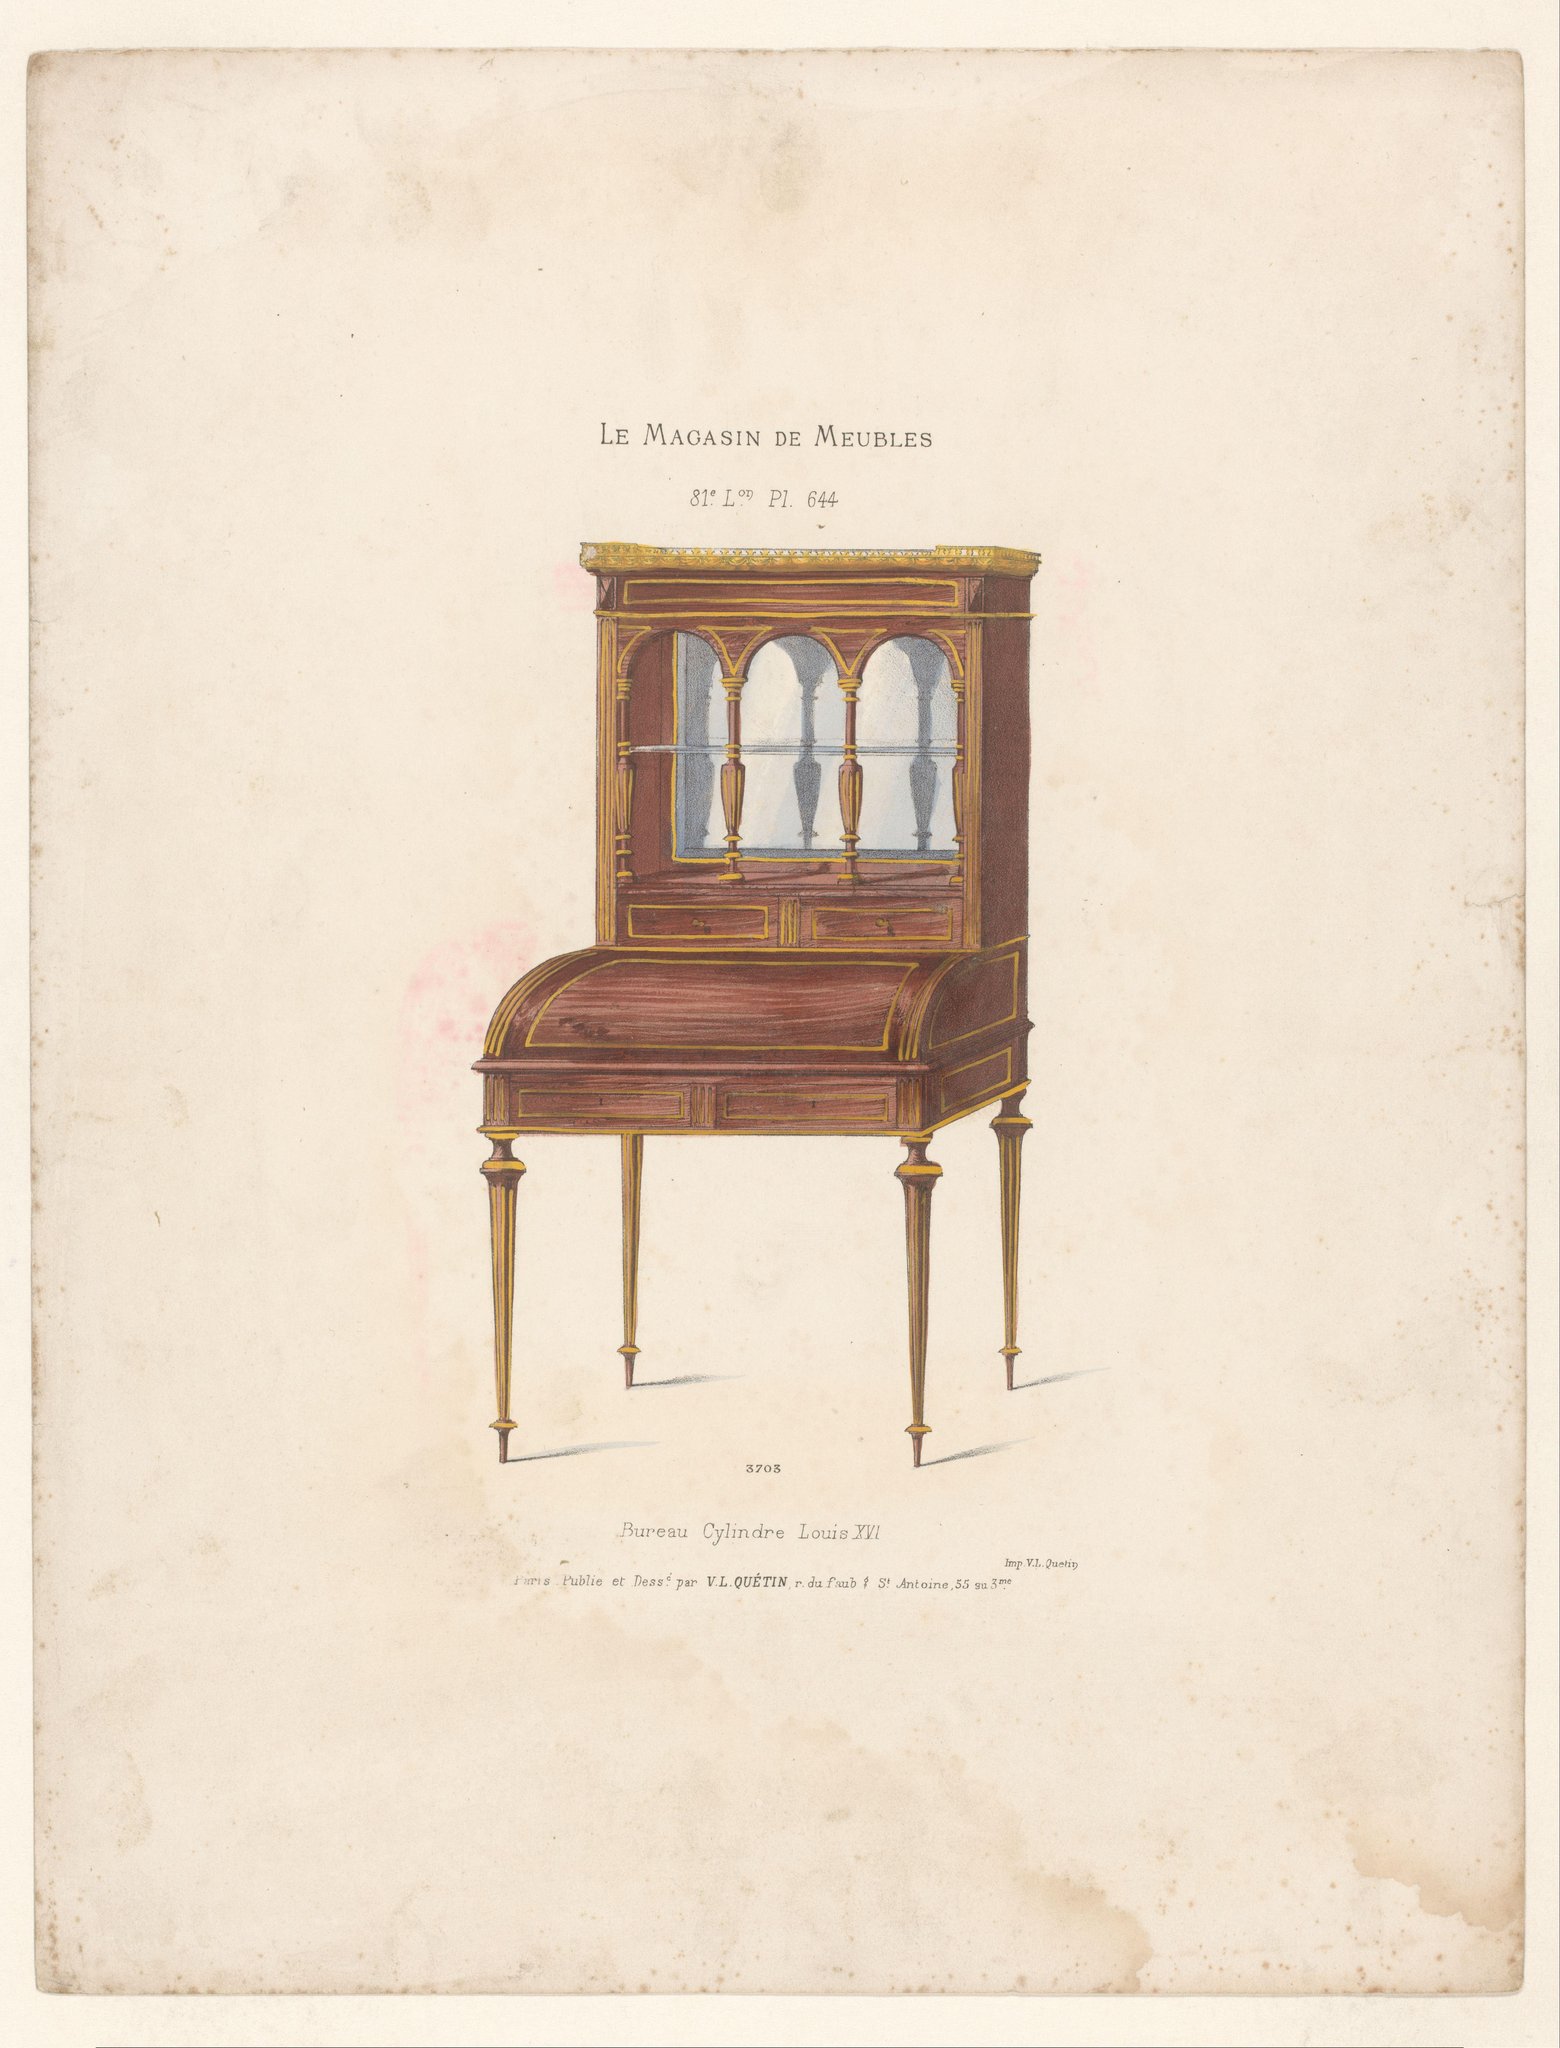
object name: print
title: Le Magasin de Meubles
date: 1878-1904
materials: paper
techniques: hand coloring, lithograph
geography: paris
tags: writing-table, writing-desk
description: Nummer 3703. Bureau met bolvormige kap. Prent uit 81e Livraison.